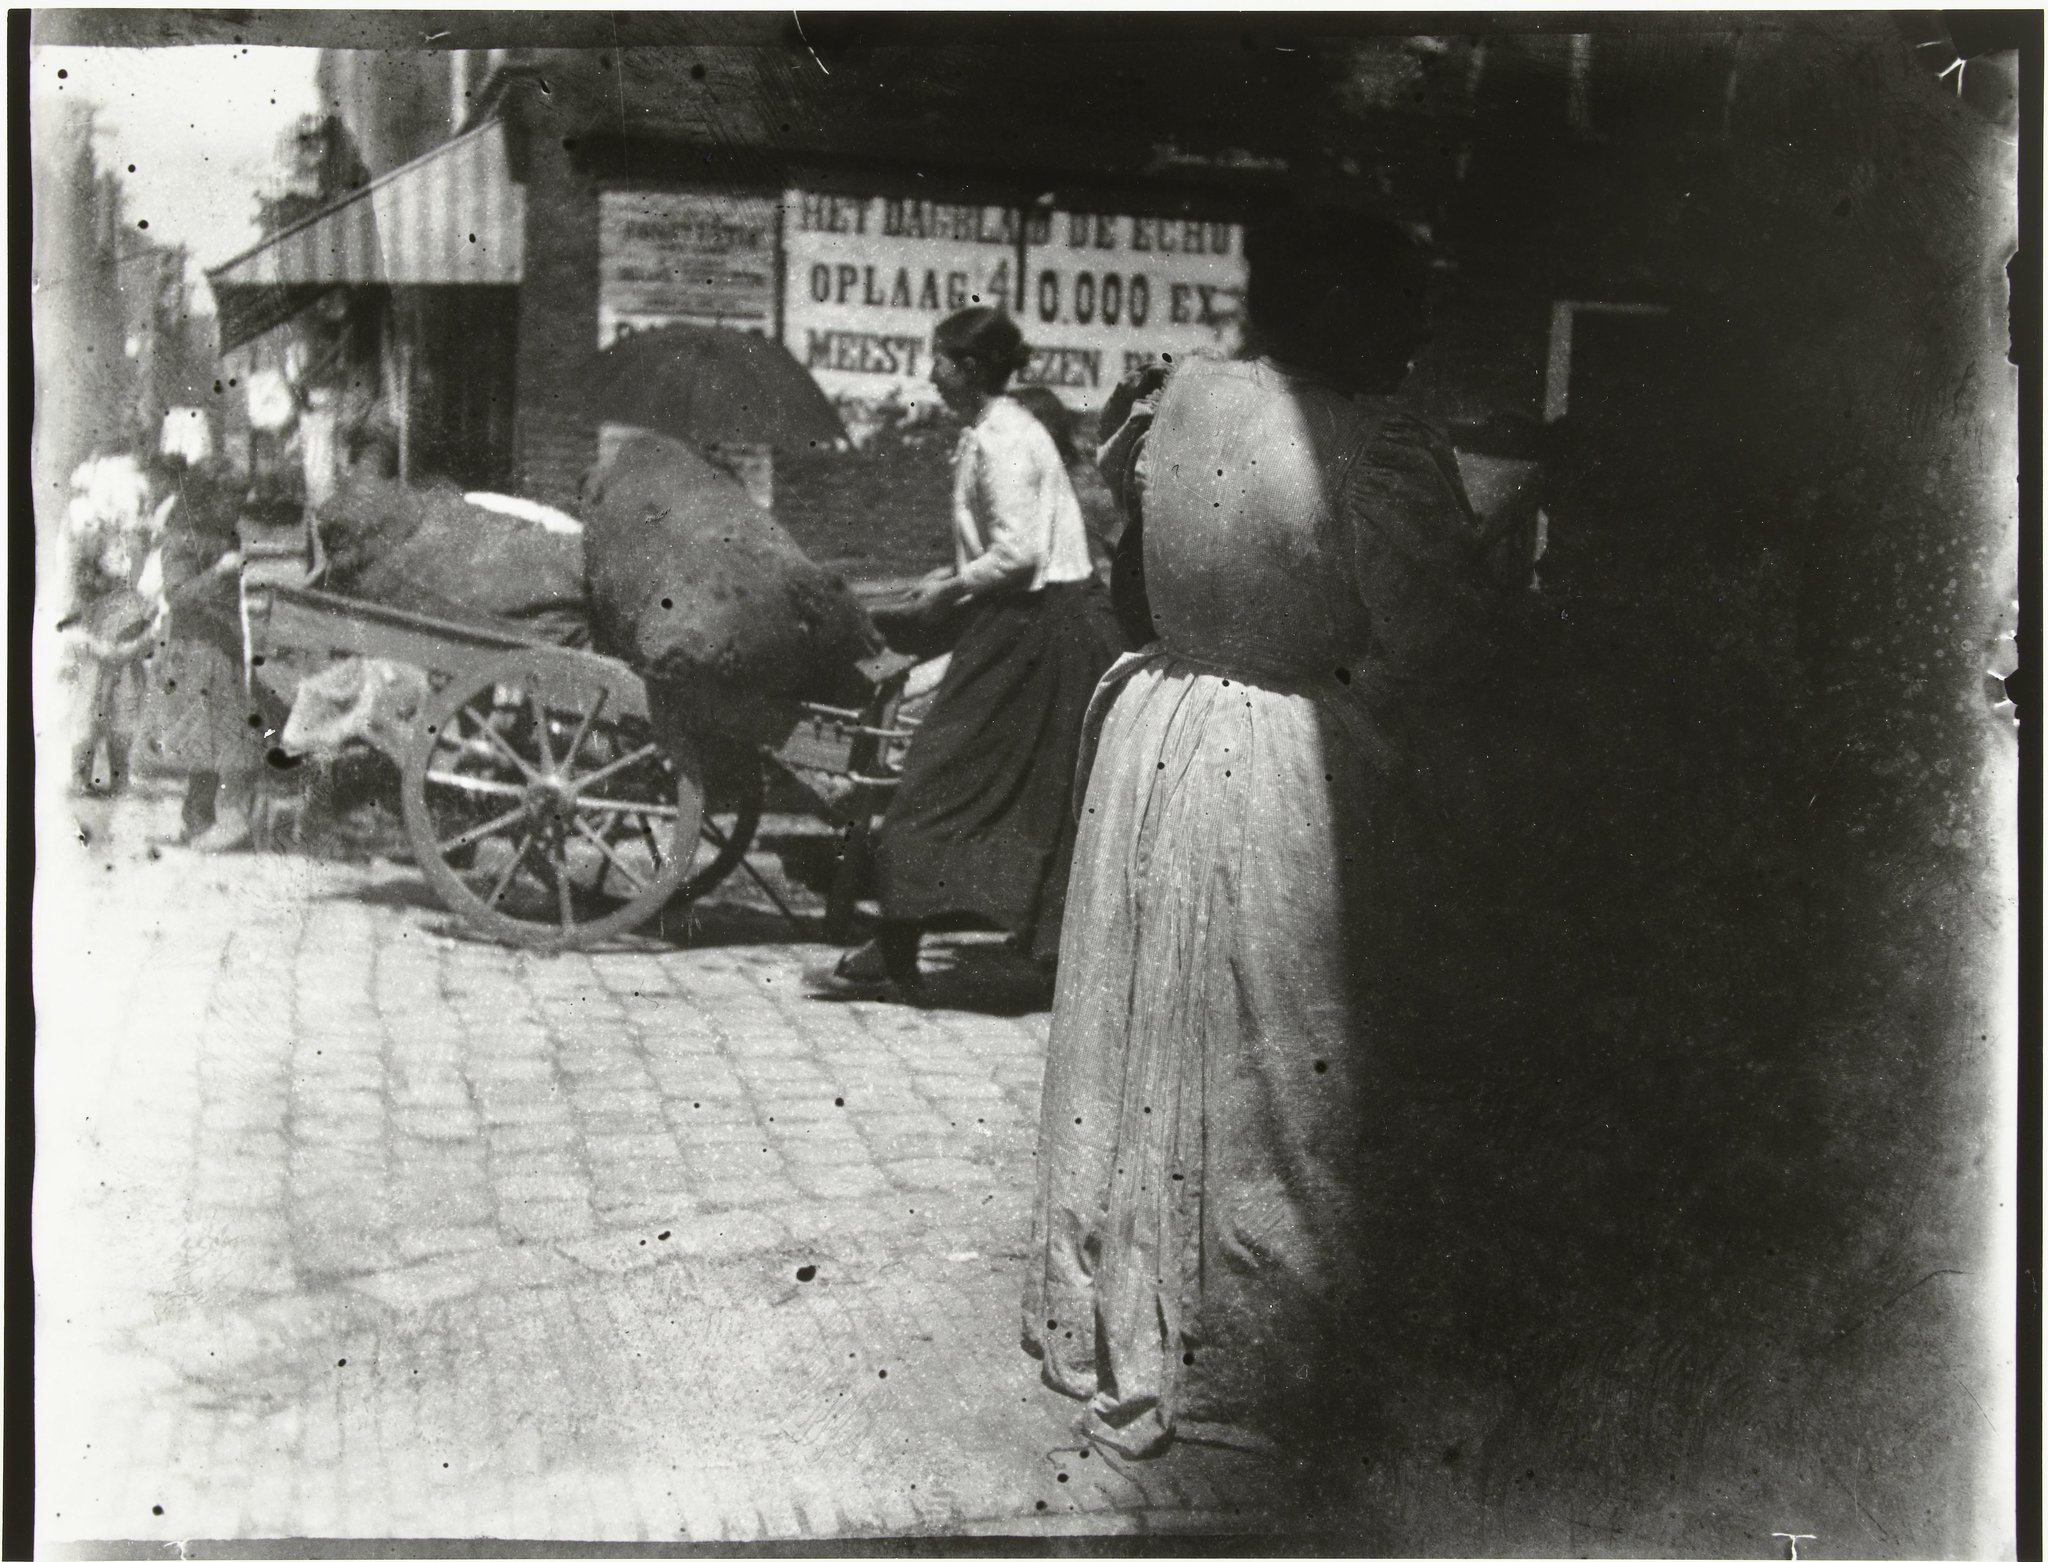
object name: photograph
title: Bedrijvigheid in de Houtkopersdwarsstraat en de Jodenbreestraat in Amsterdam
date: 1890-1910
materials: paper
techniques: gelatin silver print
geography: amsterdam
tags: jodenbreestraat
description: Moderne afdruk van negatief BR 1581 (collectie RKD).